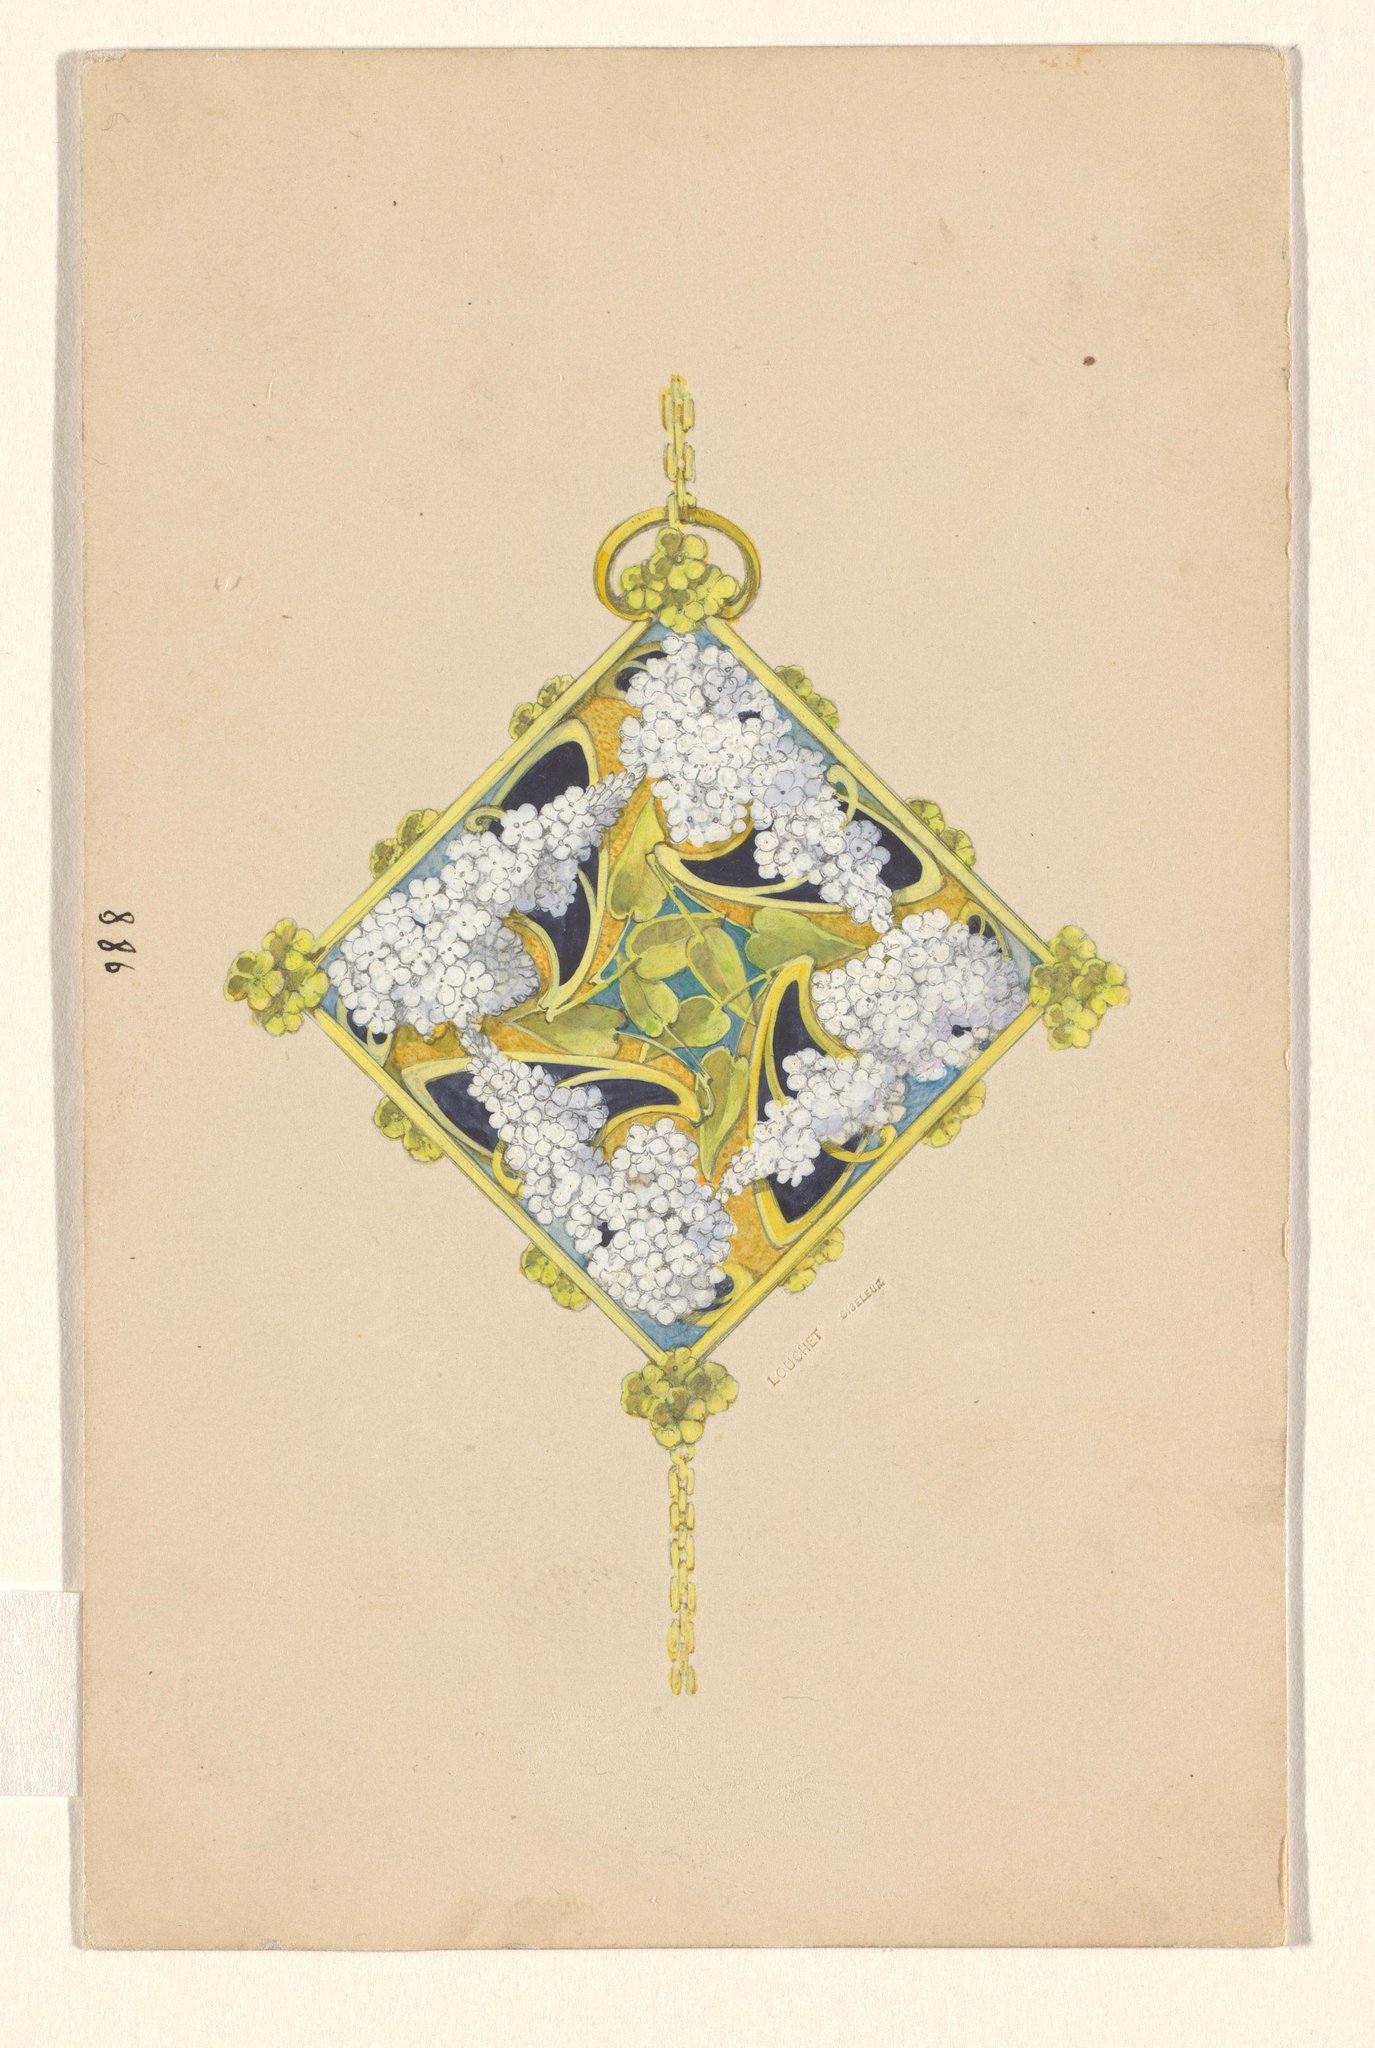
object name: design drawing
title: Ontwerp voor een hanger met bloemtakken van seringen, van geëmailleerd goud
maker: paul louchet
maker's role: painter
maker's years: 1854-1936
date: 1905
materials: ink, paper, watercolor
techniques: aquarelle, drawing, pen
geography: paris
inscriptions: name: ‘LOUCHET CISELEUR’, number: ‘886’